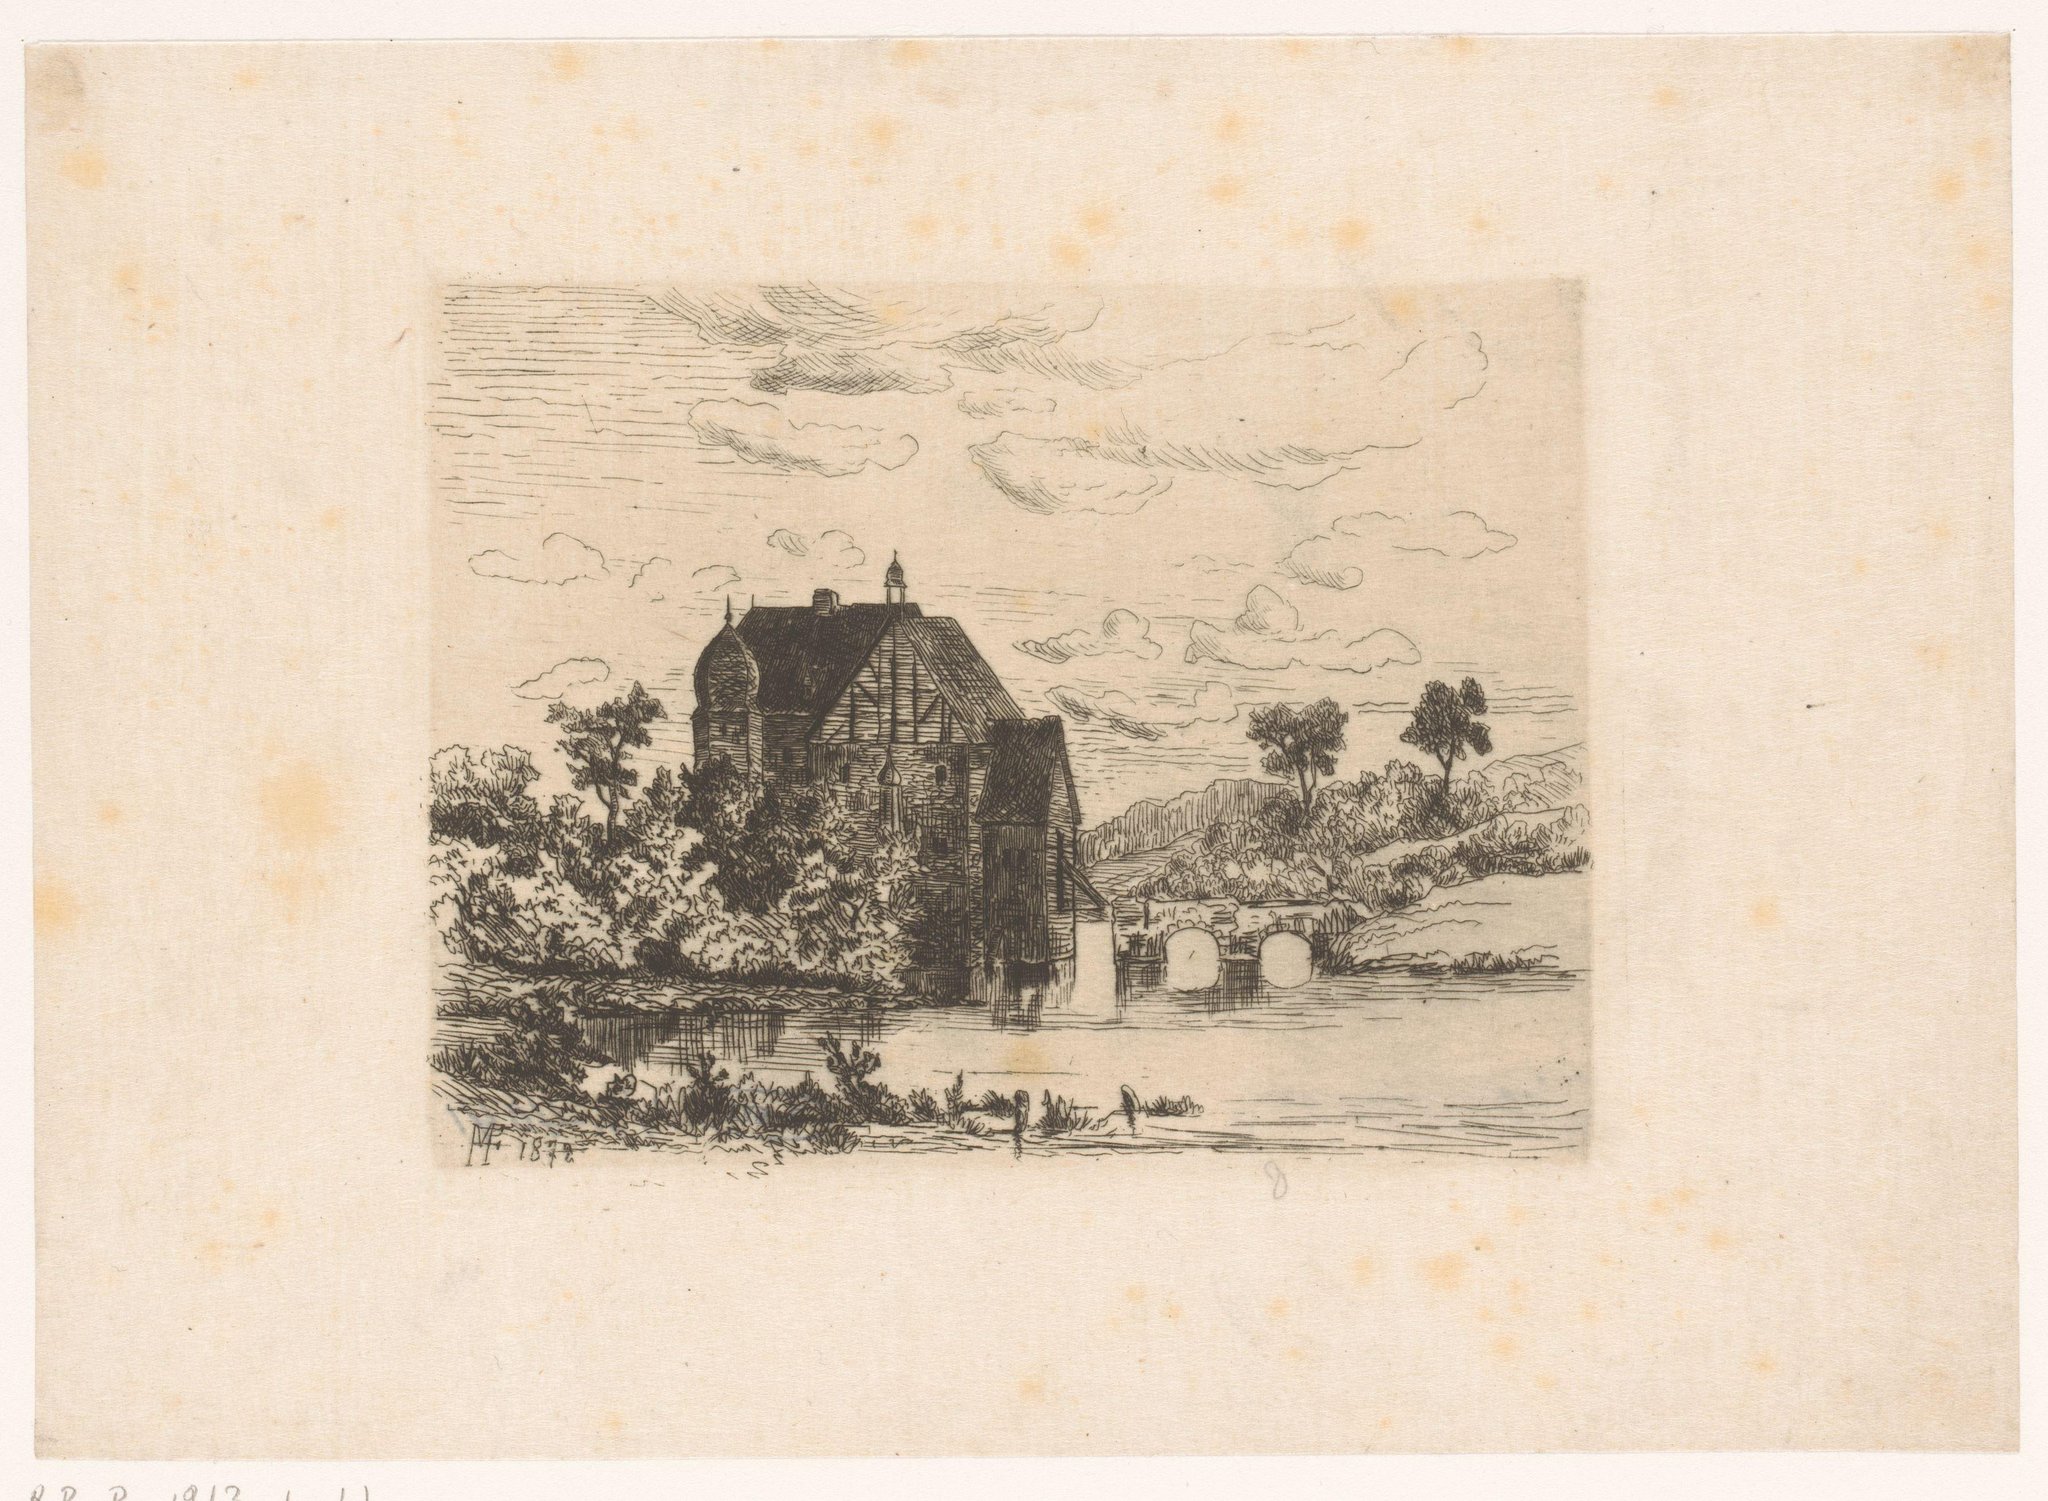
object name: print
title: Kasteel aan een rivier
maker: maria van hohenzollern-sigmaringen (gravin van vlaanderen)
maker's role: print maker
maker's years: 1845-1912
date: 1872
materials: paper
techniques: drypoint, etching, intaglio, retroussage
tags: water course, landscape with tower or castle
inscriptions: collector's mark: Lugt 2228